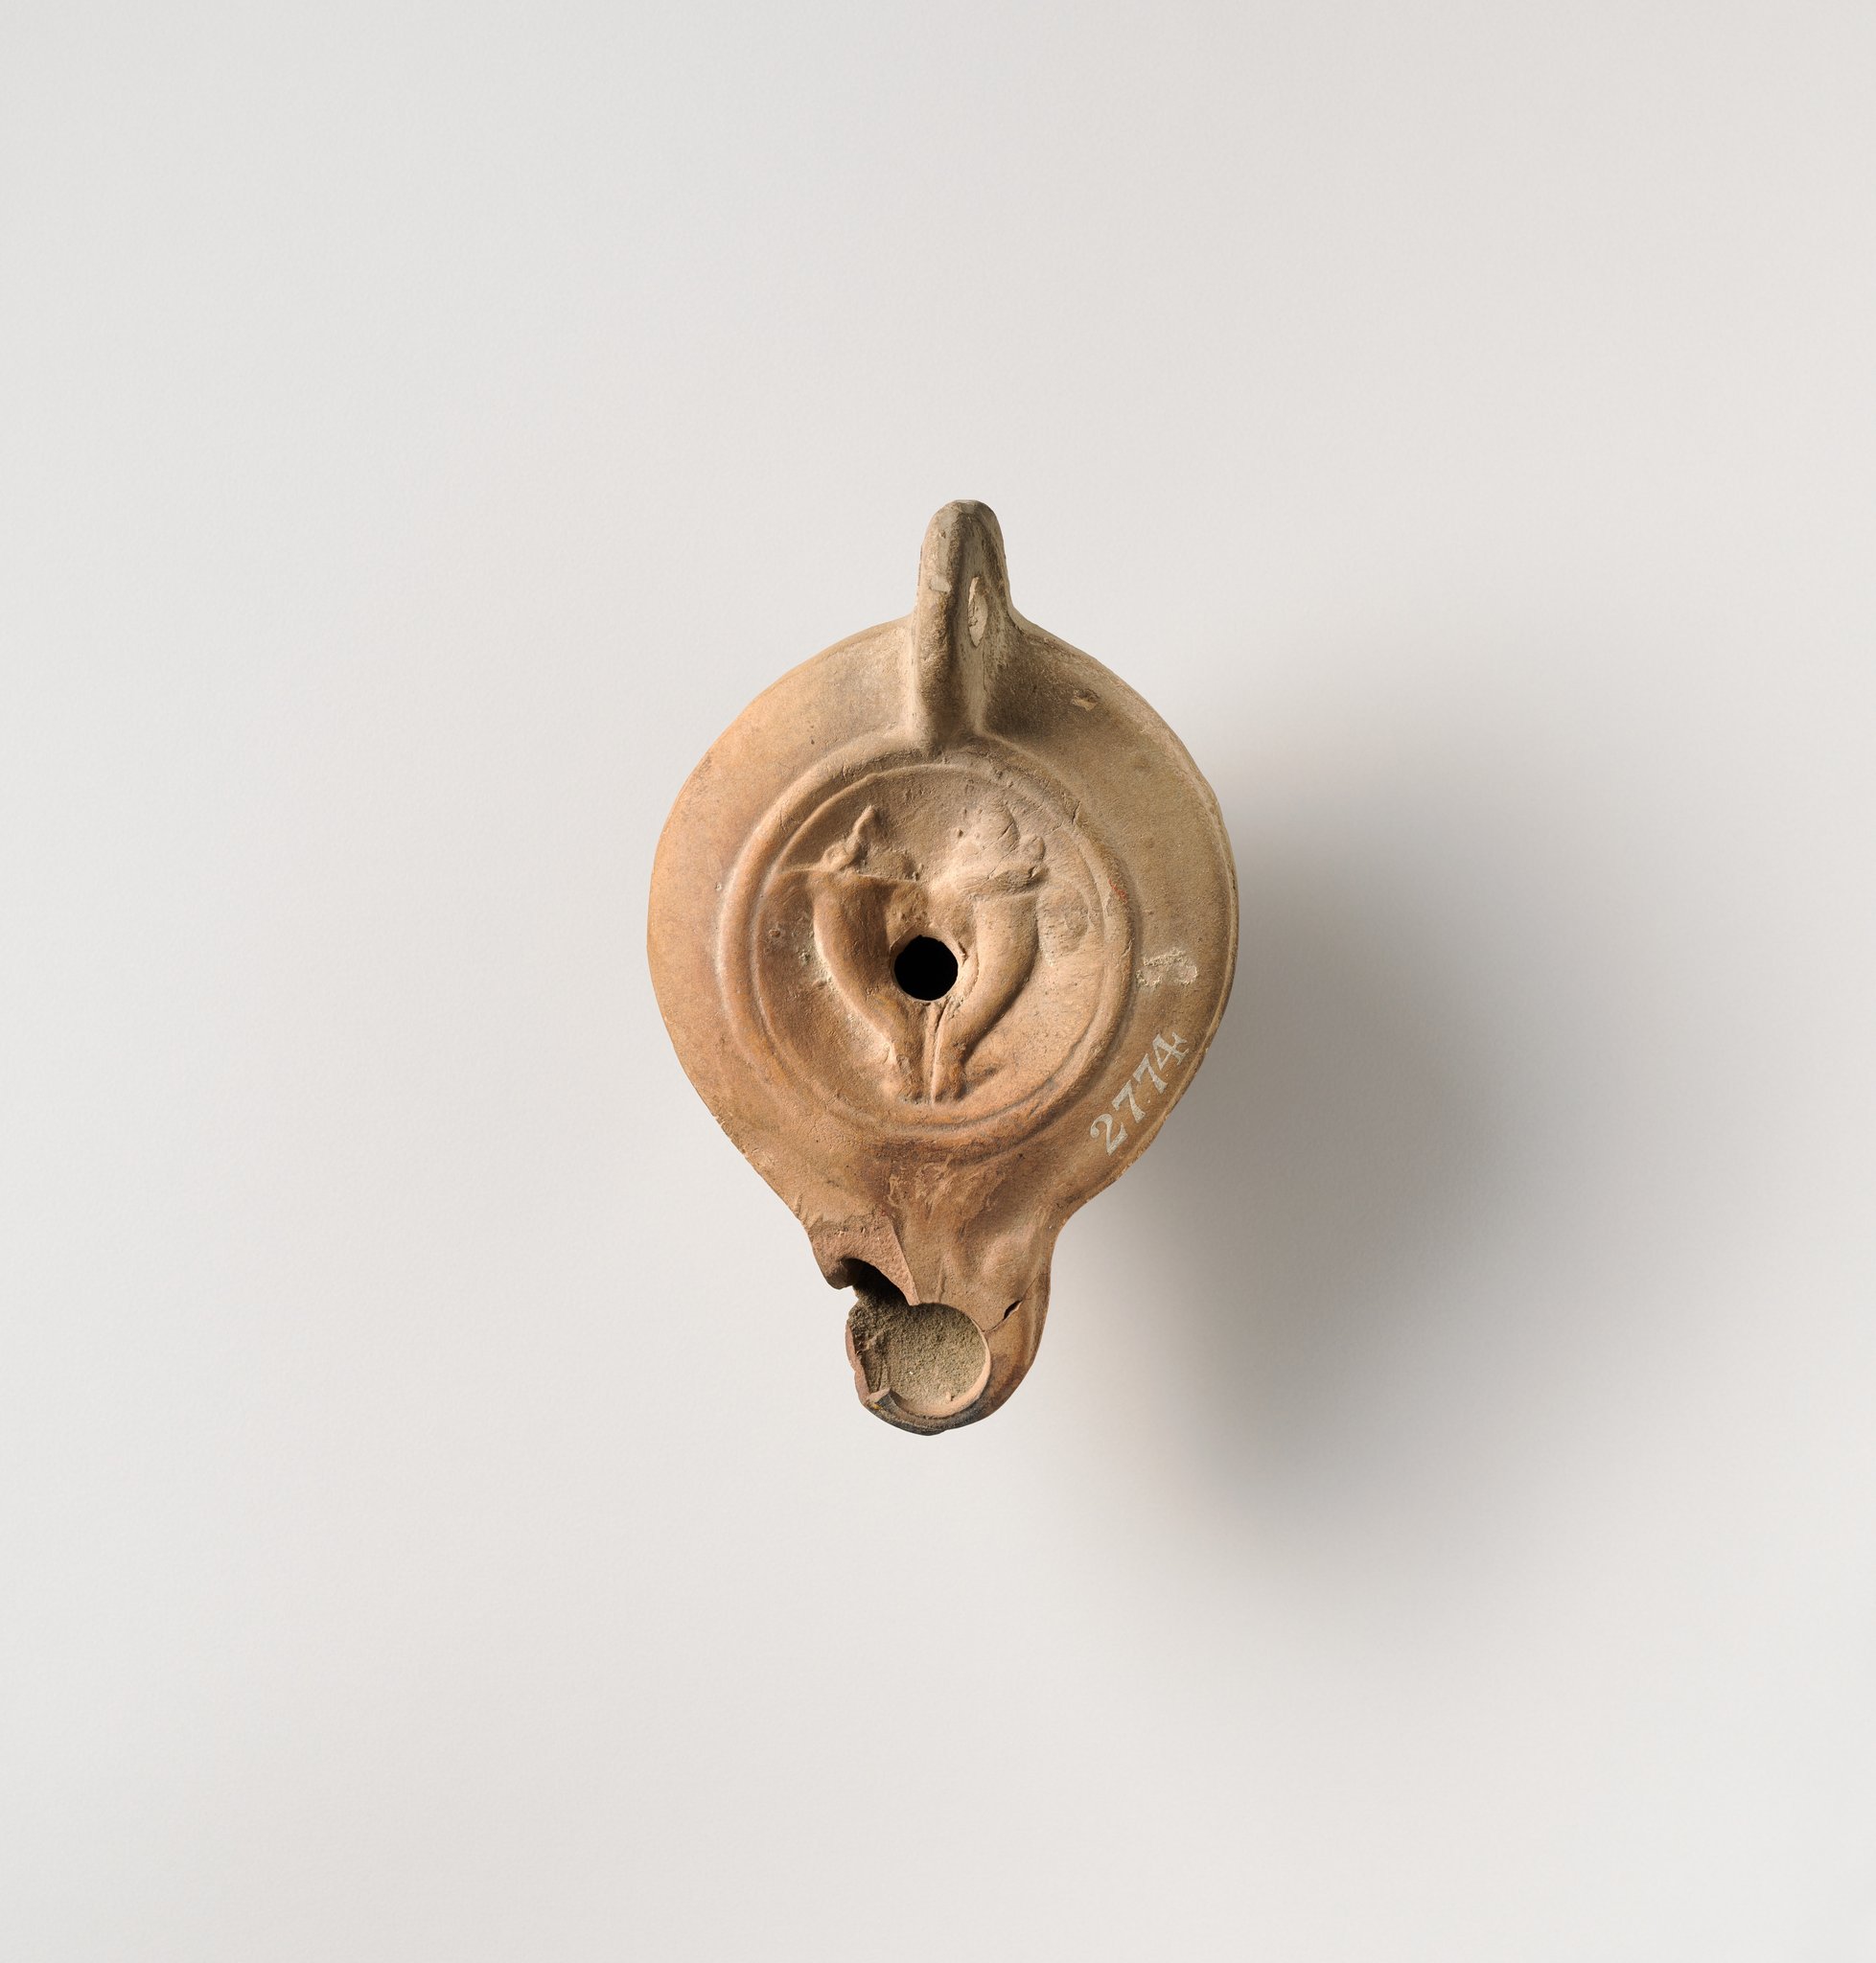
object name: lamp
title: Terracotta oil lamp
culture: roman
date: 75-150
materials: terracotta